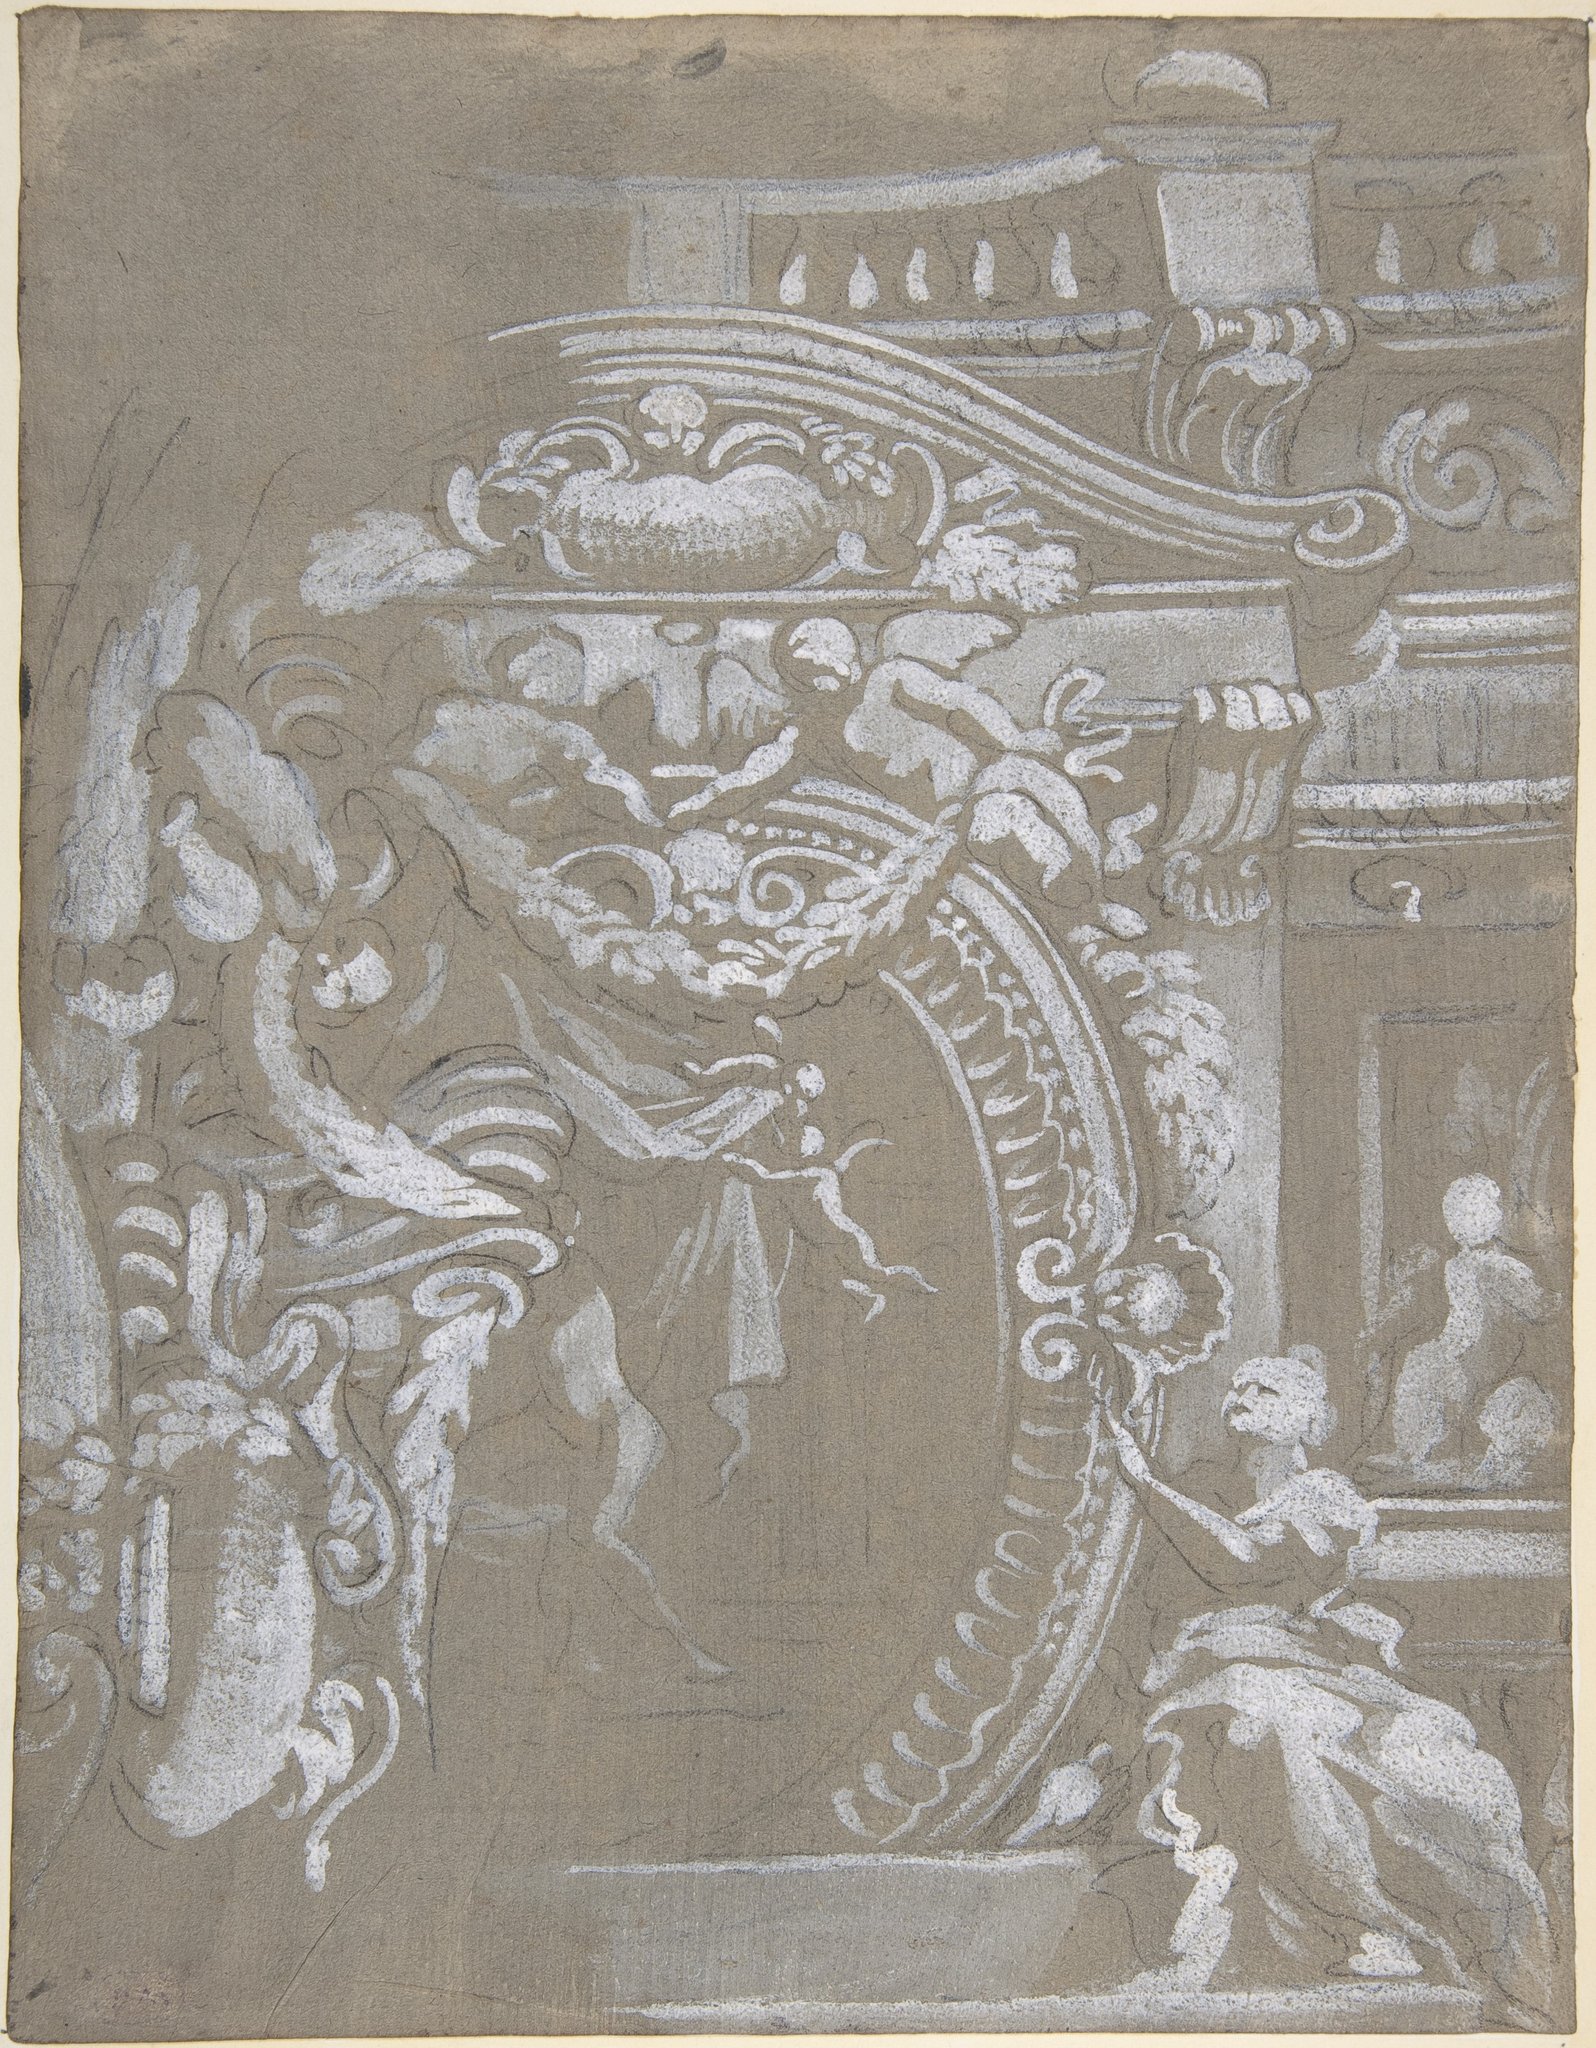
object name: drawing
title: Ornamental Design for a Wall Monument Surmounted by a Balustrade with Human Figures, Angels Holding Garlands and Draperies (recto and verso)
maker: gregorio de' ferrari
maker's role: artist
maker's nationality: italian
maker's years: 1647-1726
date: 1647-1726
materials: chalk, gouache, paper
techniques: brush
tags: human figures,garlands,ornament,angels